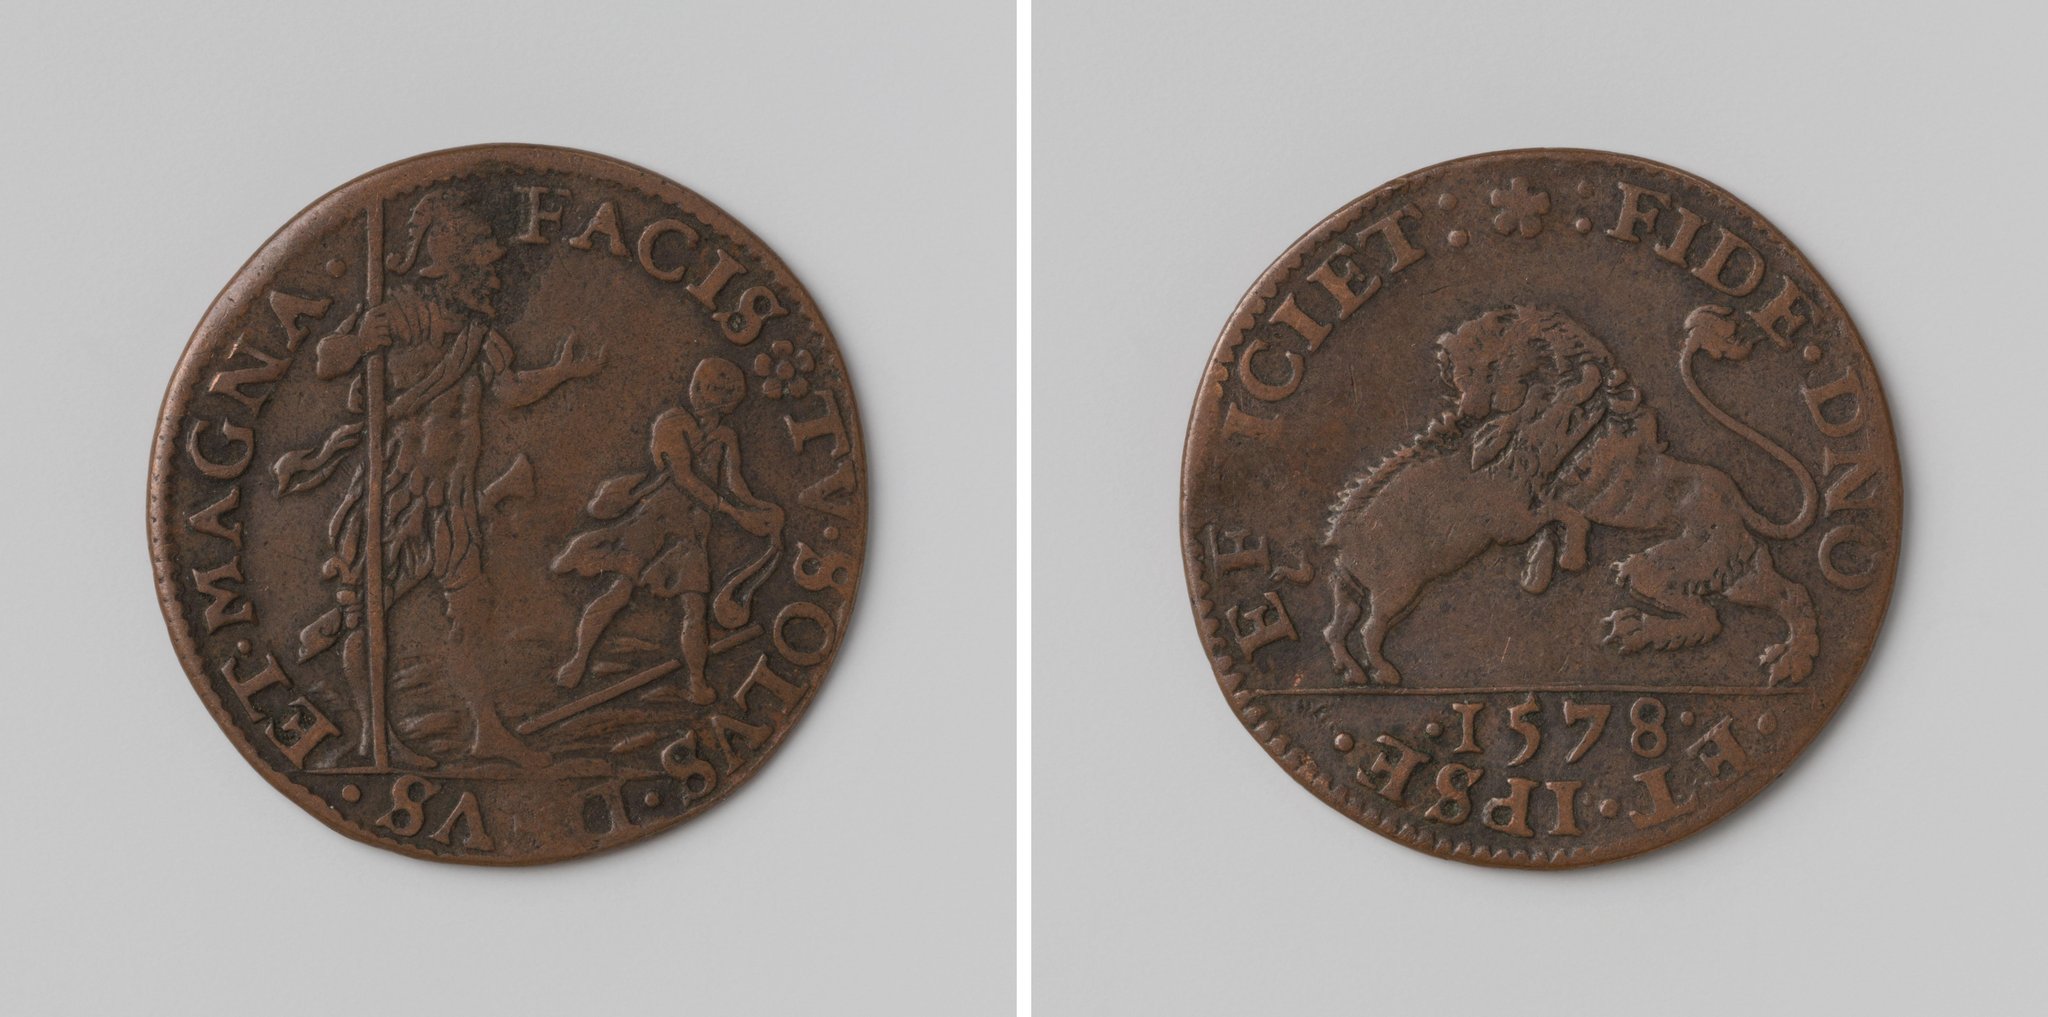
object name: jeton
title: Succes in de strijd tegen Spanje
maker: Anonymous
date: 1578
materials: copper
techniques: striking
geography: dordrecht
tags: tachtigjarige oorlog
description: Koperen penning. Voorzijde: Goliath met speer in volle wapenrusting en David met zijn slinger binnen omschrift. Keerzijde: Nederlandse leeuw bespringt Spaans everzwijn boven jaartal binnen omschrift